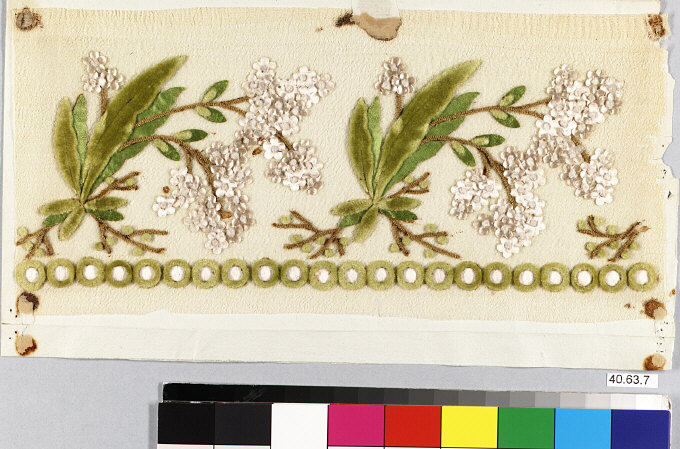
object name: border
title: Dress border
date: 1801-1833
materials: silk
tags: flowers